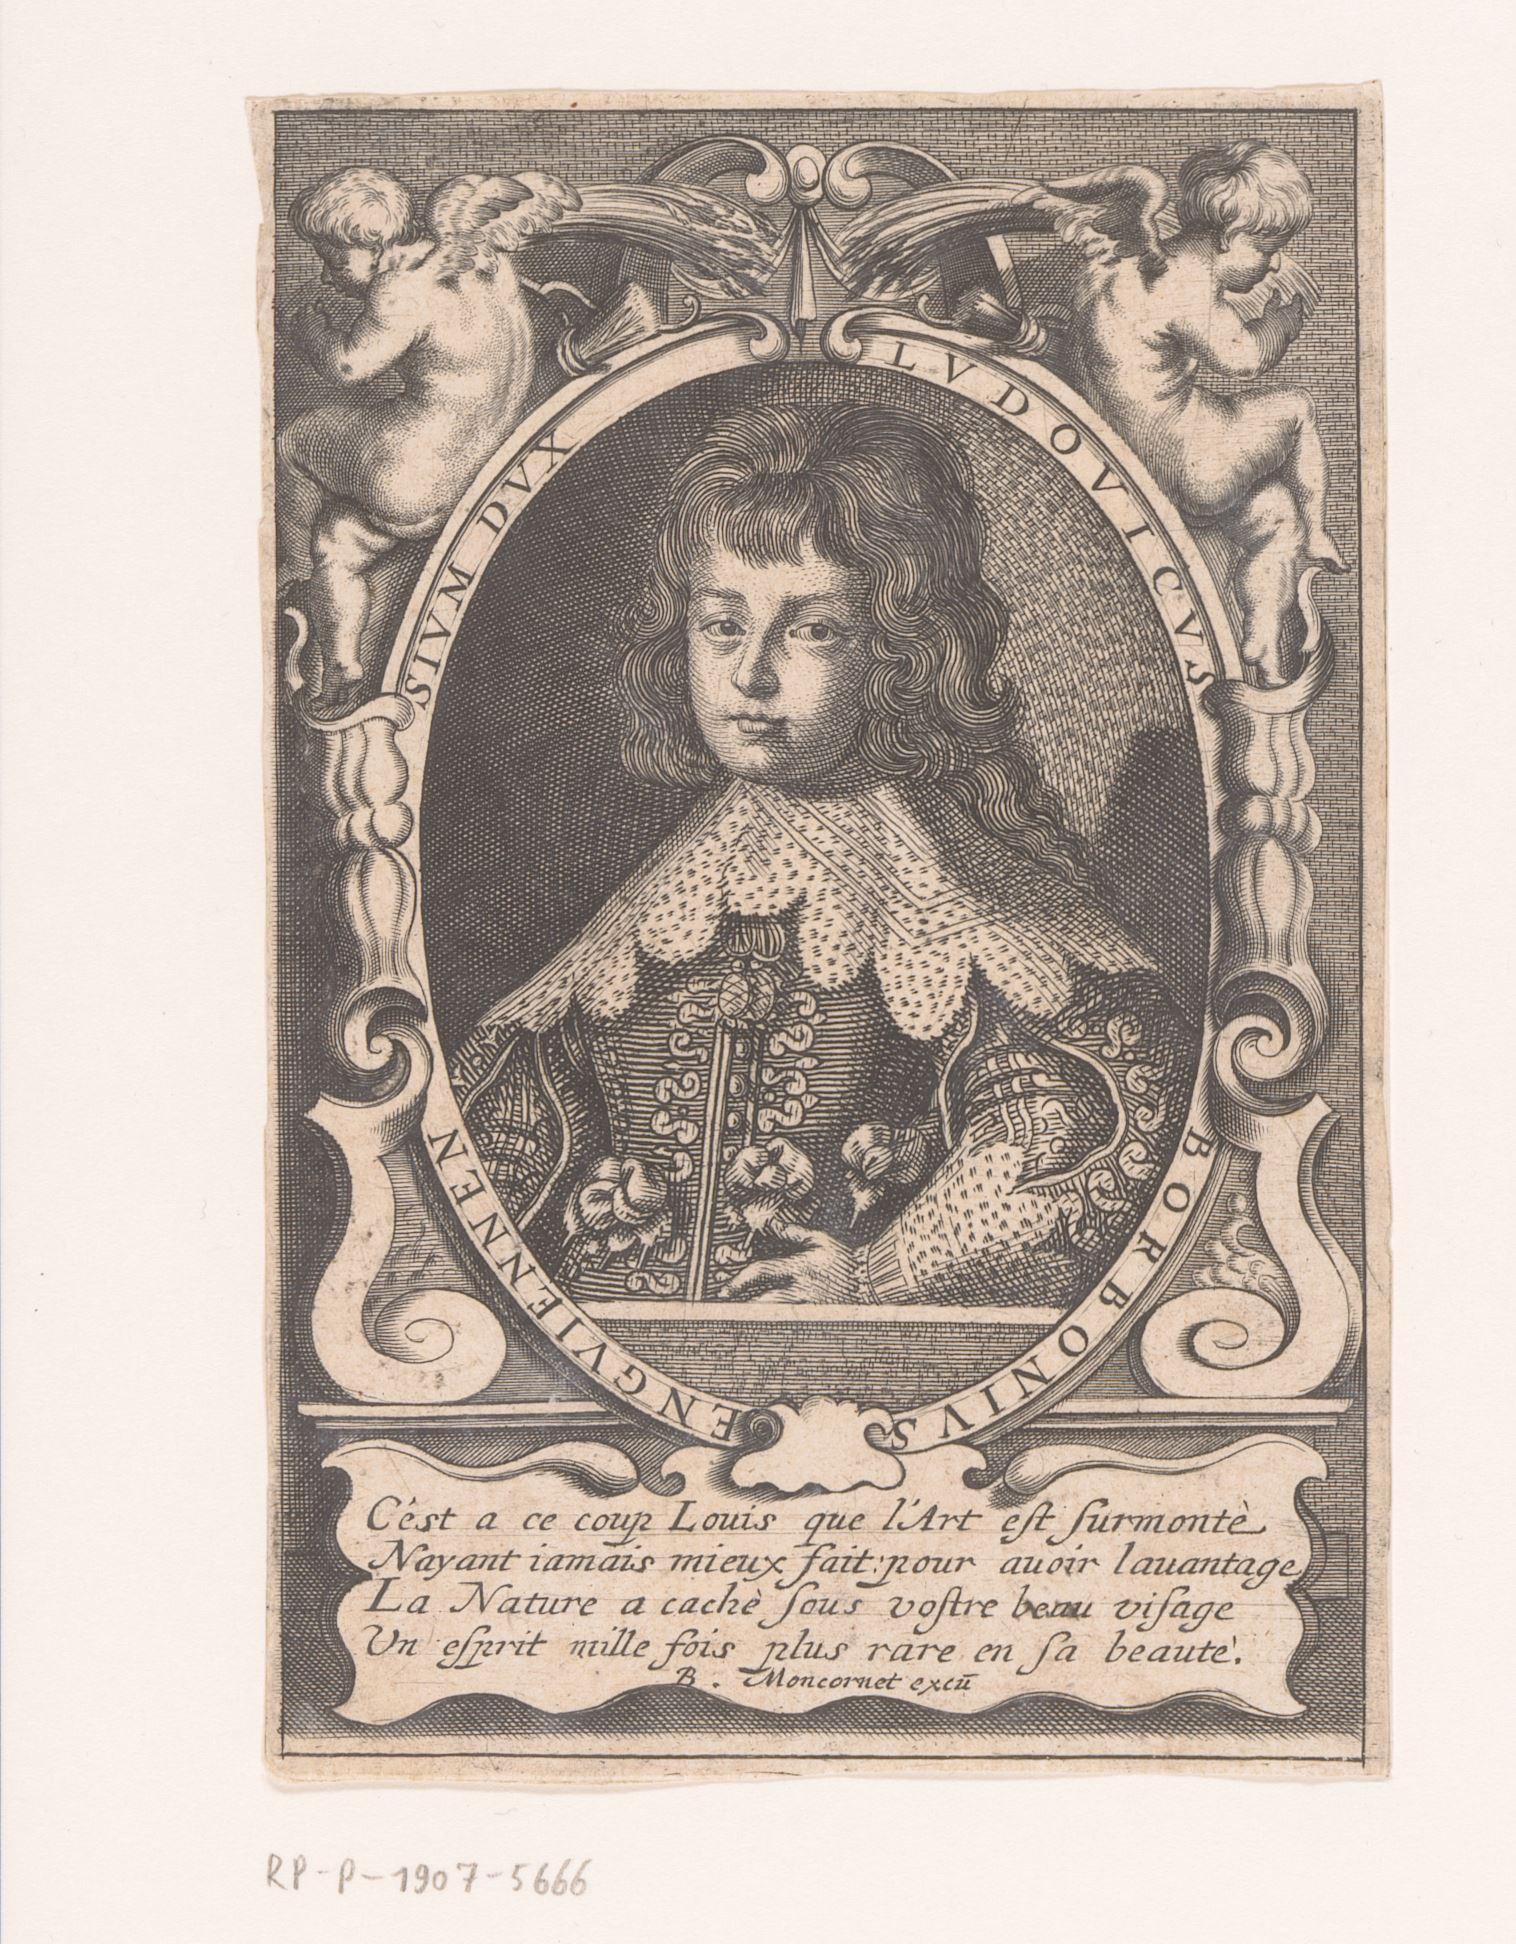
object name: print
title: Portret van Lodewijk II van Bourbon-Condé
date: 1631-1668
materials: paper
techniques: engraving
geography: paris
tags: lodewijk ii de bourbon-condé (hertog van enghien), ranks in the army, historical persons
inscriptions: collector's mark: Lugt 2228